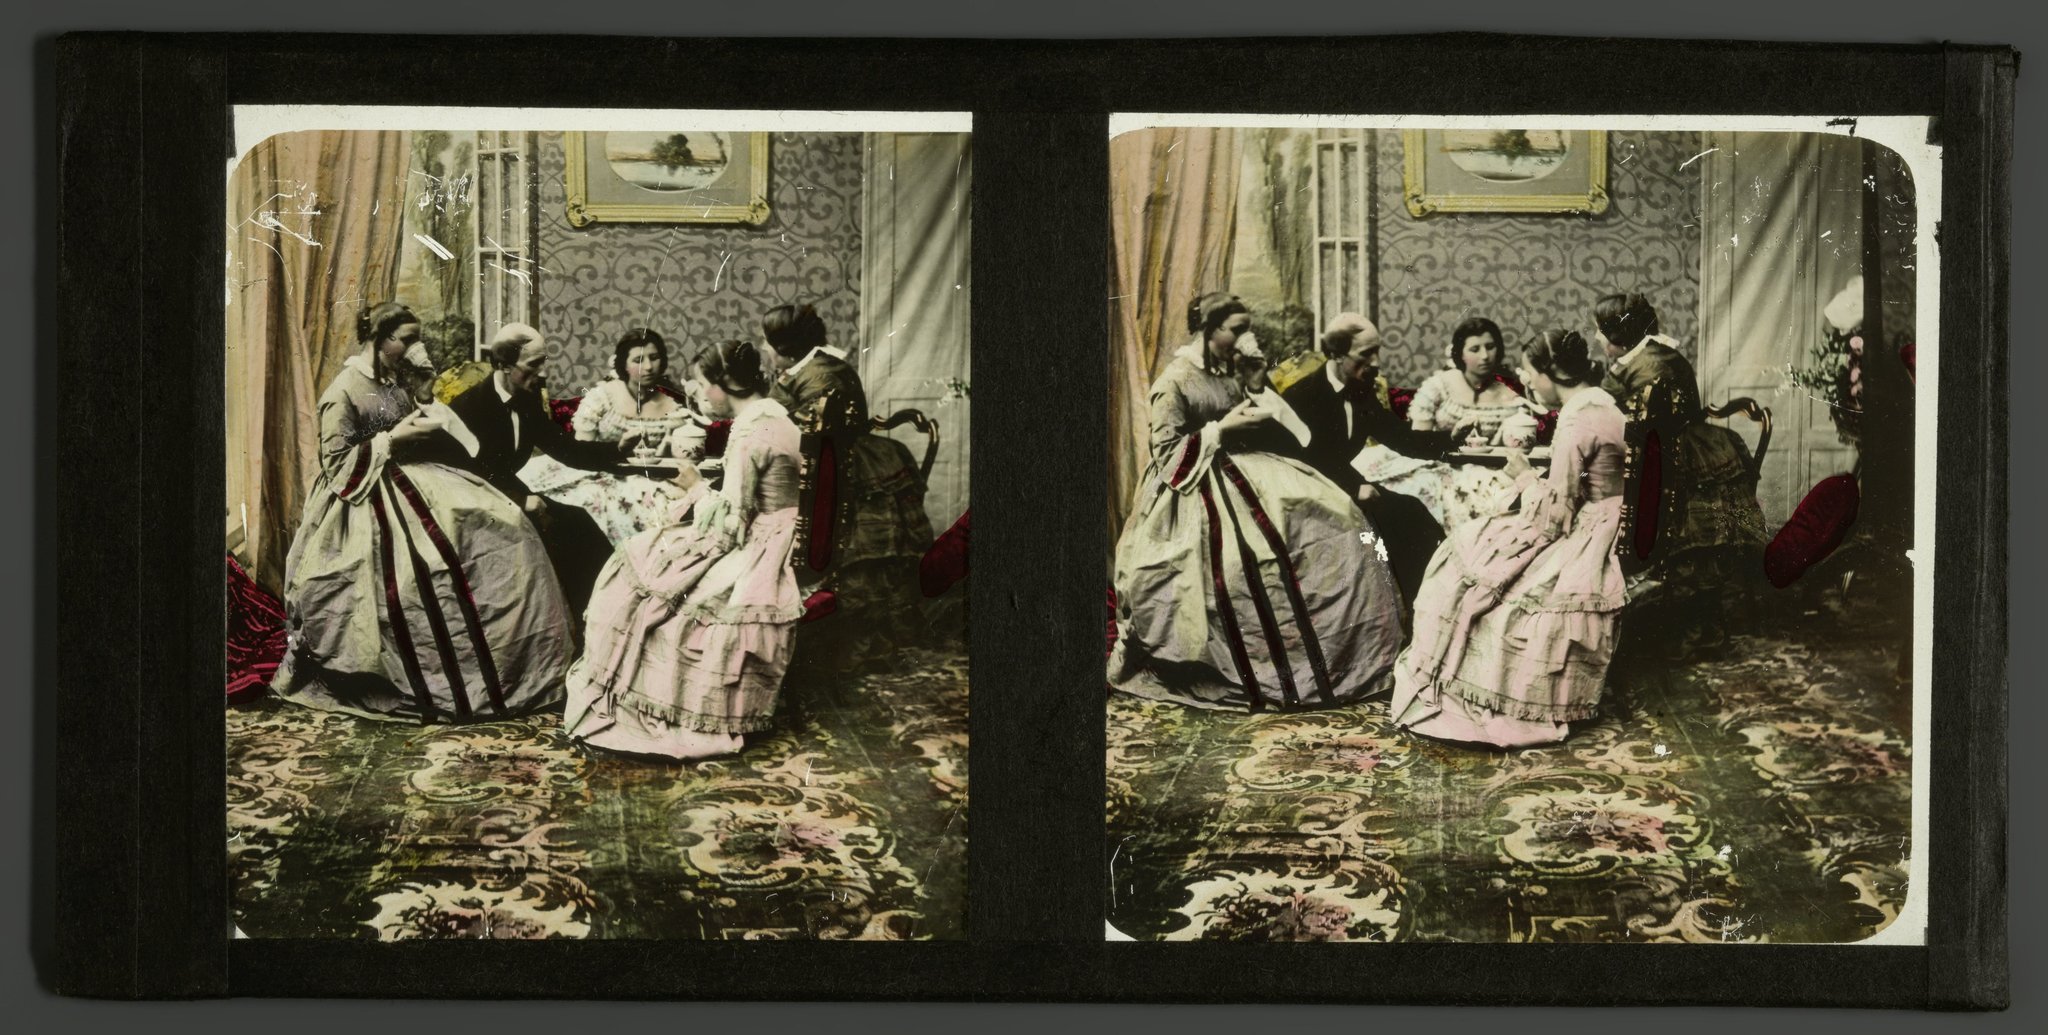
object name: stereoscopic photograph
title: Gezelschap rond tafel, thee drinkend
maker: Anonymous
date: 1880-1900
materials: glass, paper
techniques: hand coloring, slide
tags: high tea